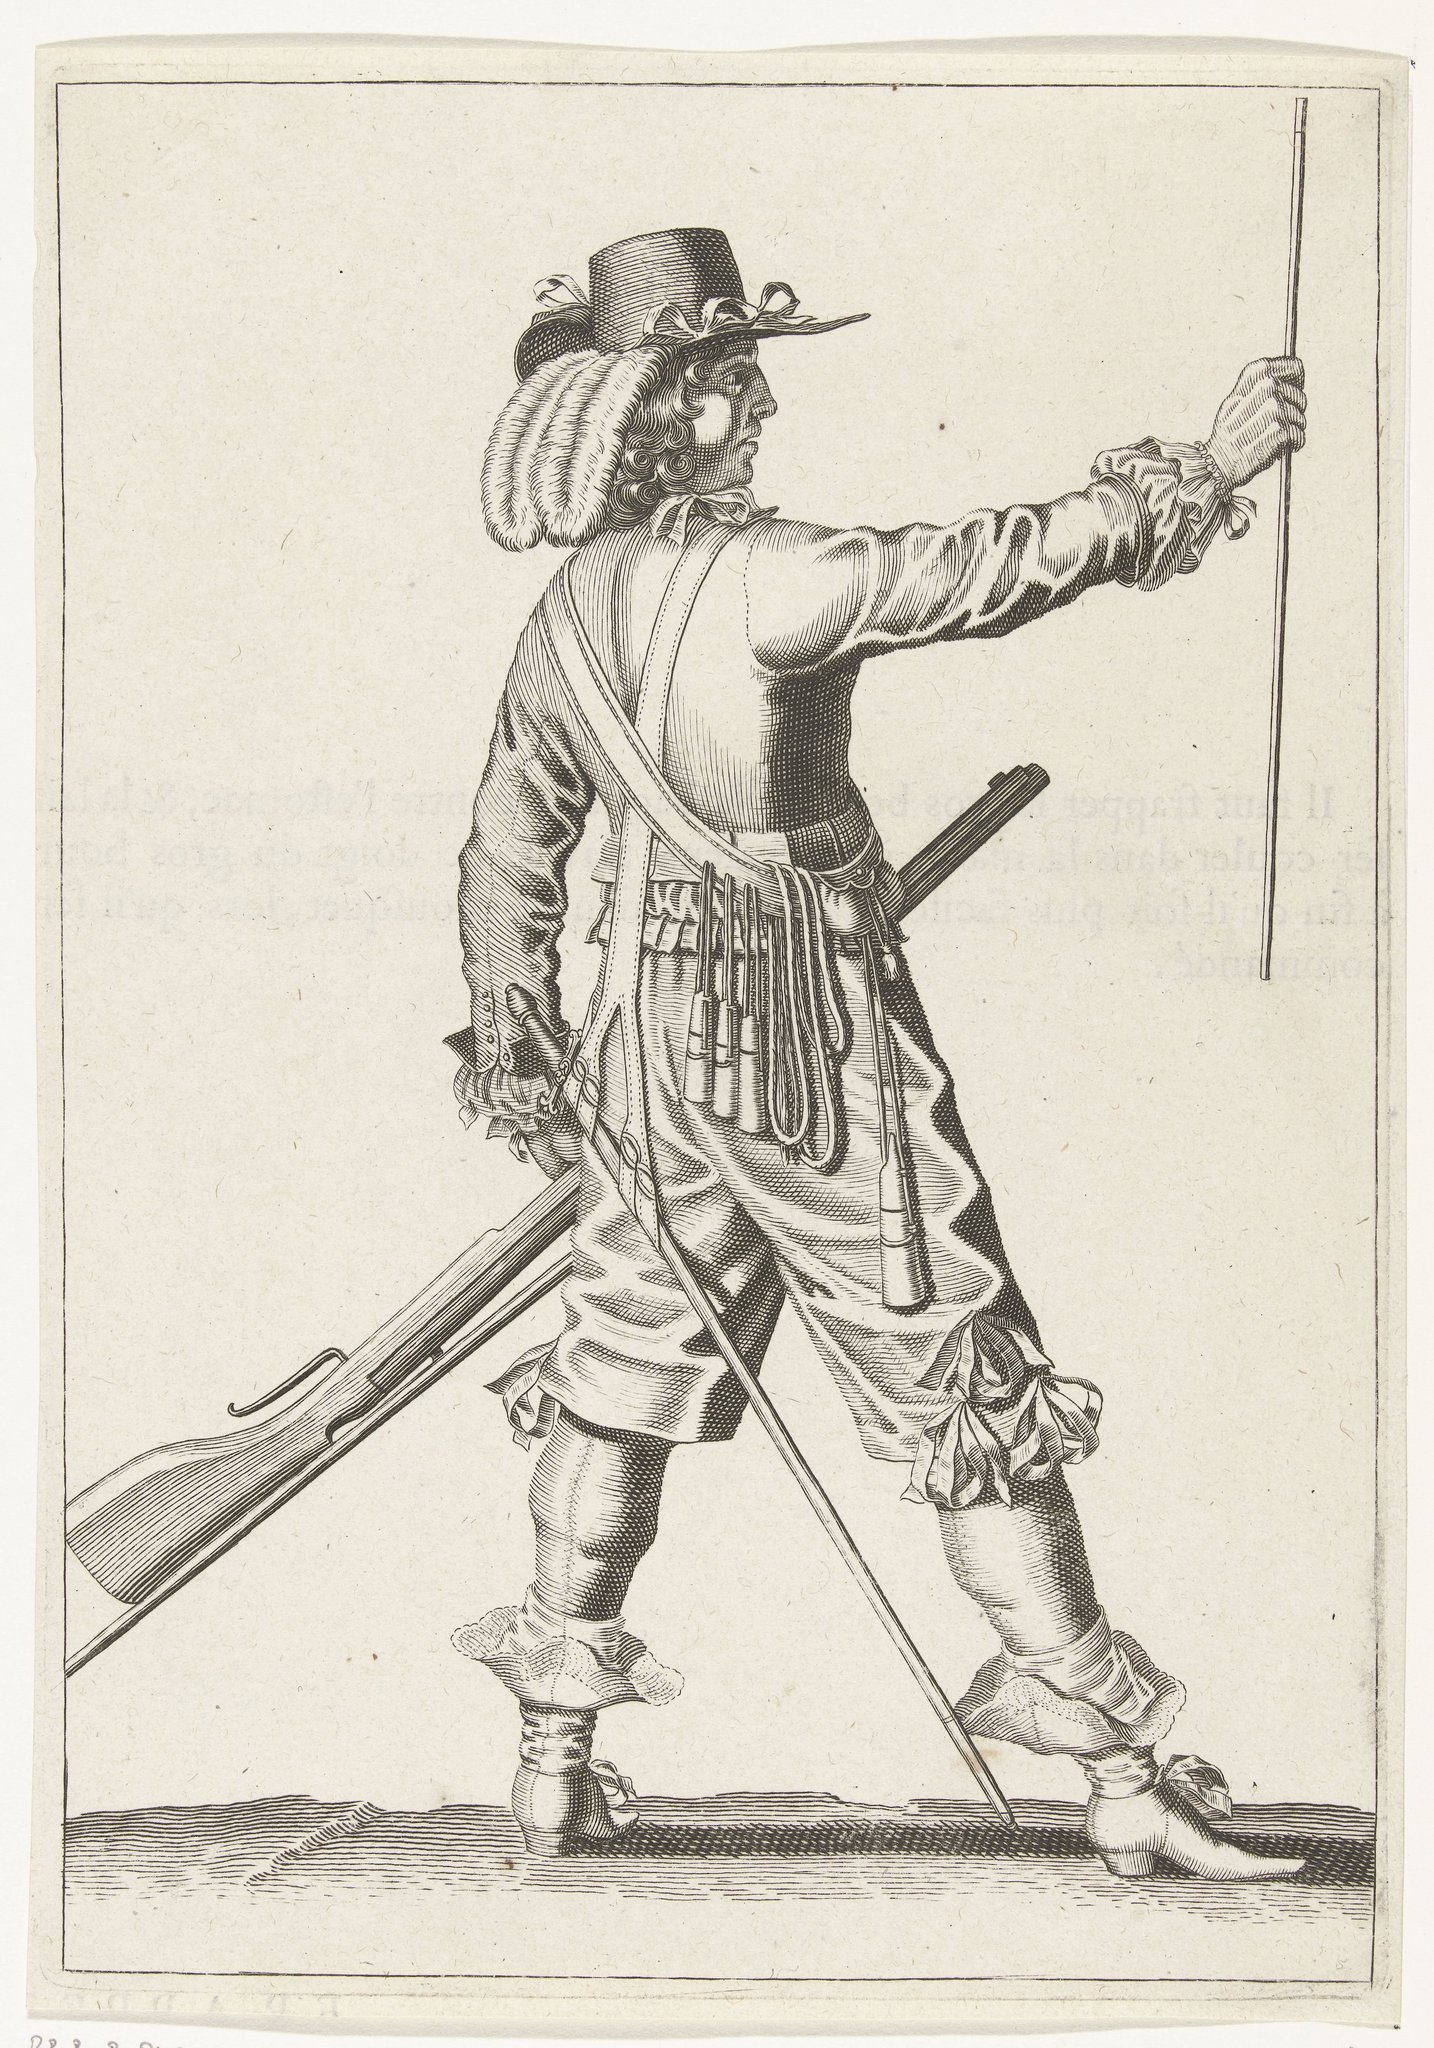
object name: print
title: Soldaat houdt de laadstok van zijn musket recht voor zich, ca. 1645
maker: petrus rucholle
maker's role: print maker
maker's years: 1618-1647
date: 1645-1647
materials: paper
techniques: engraving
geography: southern netherlands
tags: handling of weapons ~ military training, weapons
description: Een soldaat, ten voeten uit, die met zijn rechterhand de laadstok van zijn musket recht voor zich houdt. In zijn linkerhand het musket. Bedrukt op achterzijde met tekst in het Frans. Nieuwe voorstelling niet ontleend aan de instructies voor het hanteren van het musket in de Wapenhandelinghe van J. de Gheyn. Krijgswezen rond 1600.